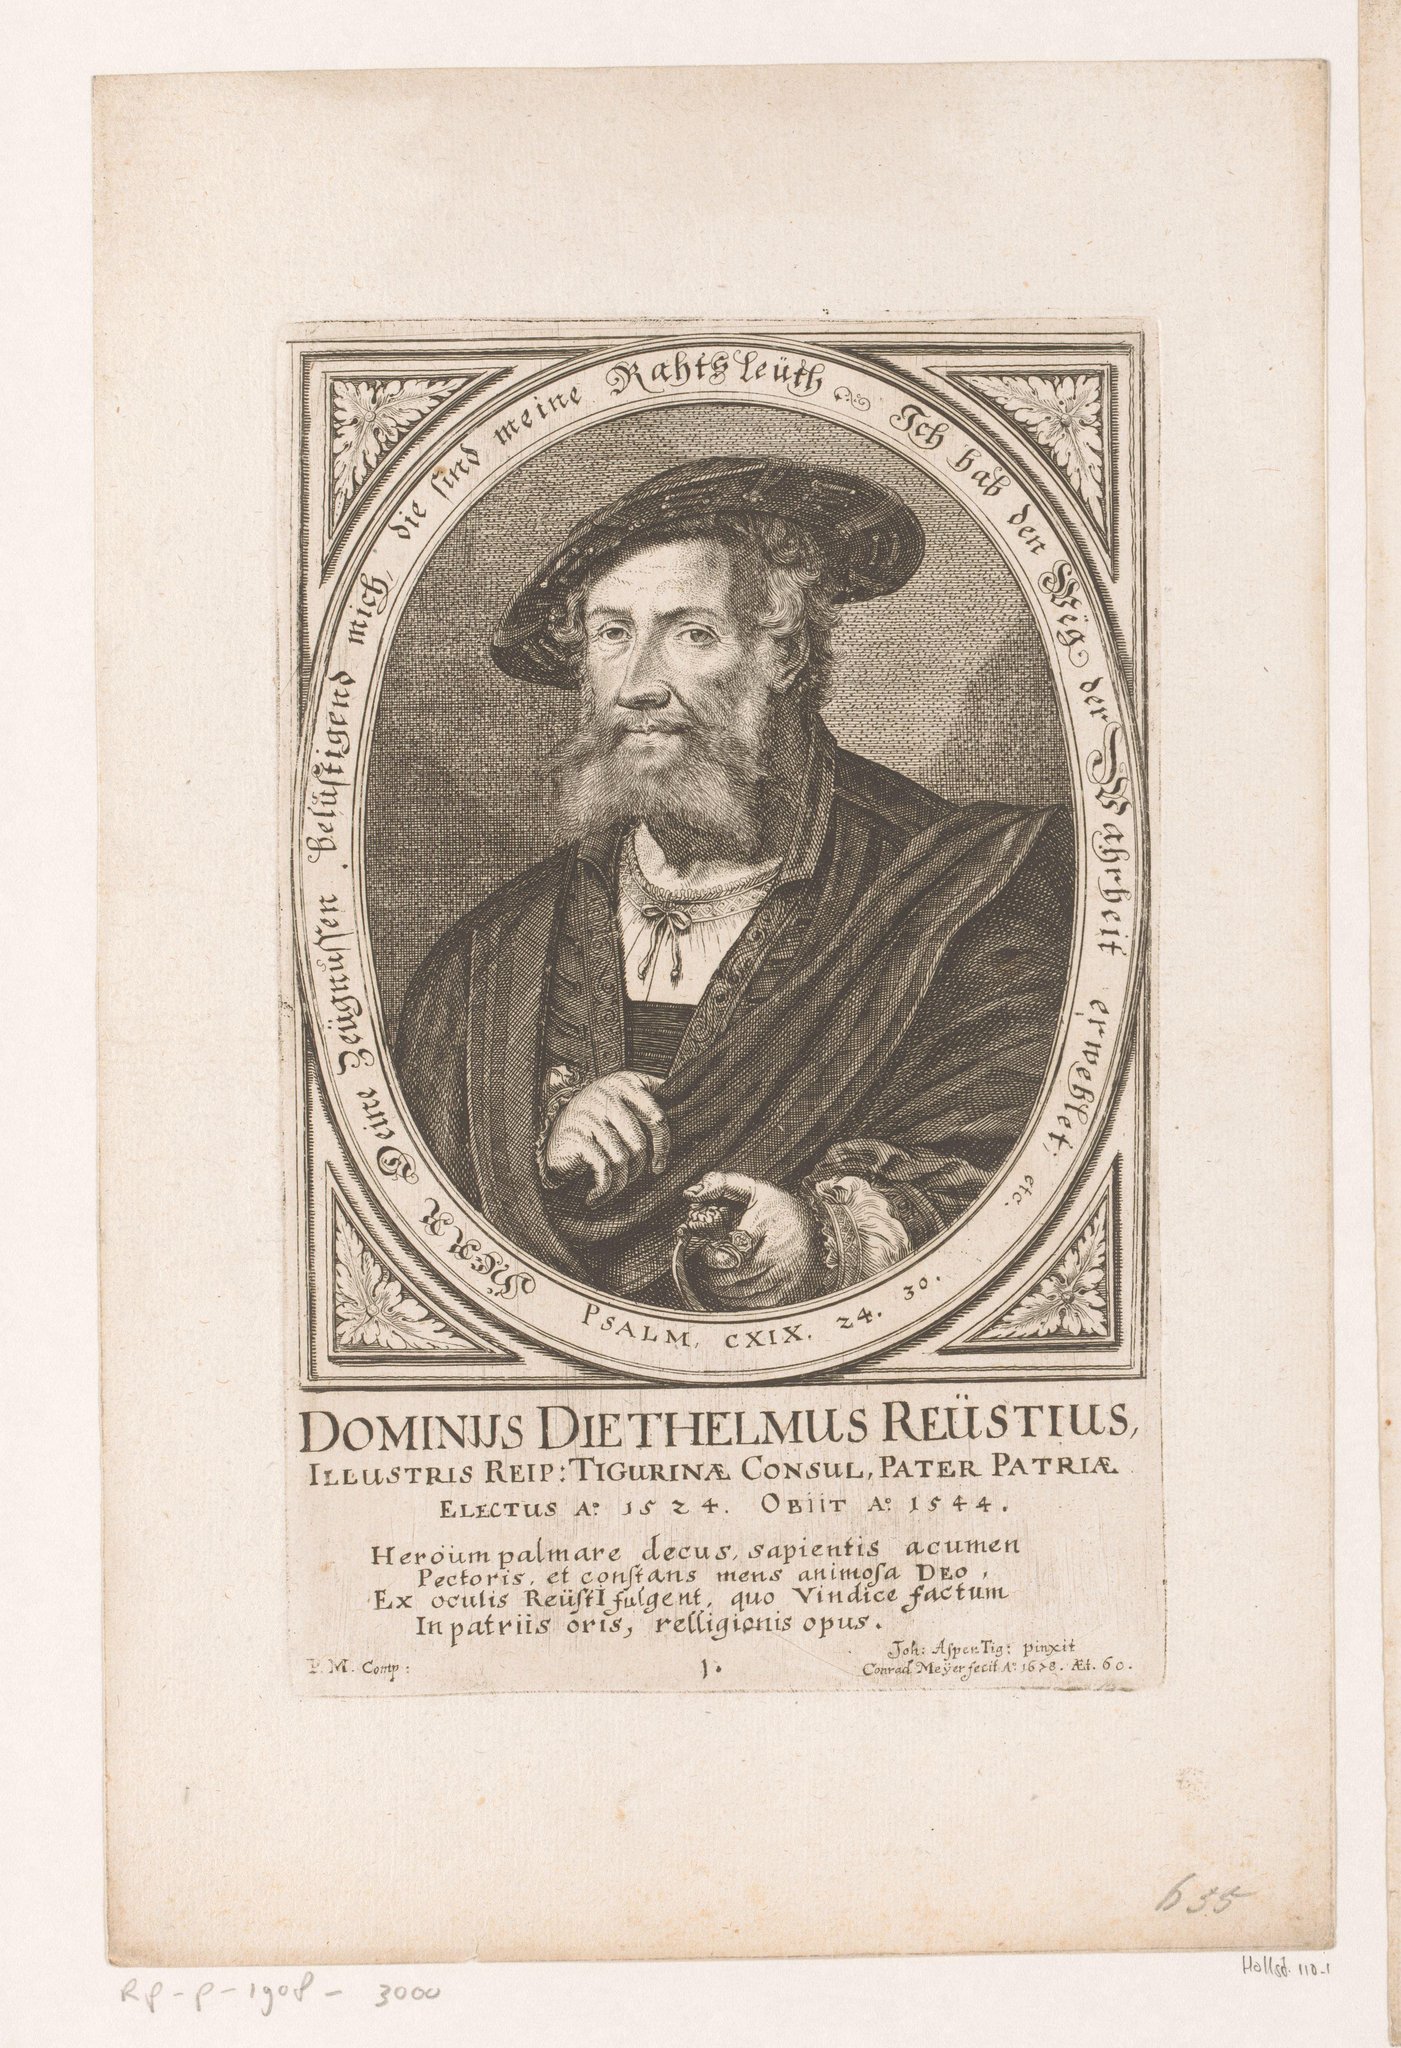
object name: print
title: Portret van Diethelm Reust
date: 1678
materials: paper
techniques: engraving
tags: mayor, burgomaster, historical persons, hacking and thrusting weapons: sword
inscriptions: collector's mark: Lugt 2228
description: Onderdeel van een serie van 67(?) portretten van burgemeesters van Zürich. Zie Hollstein German 110, 1-26.